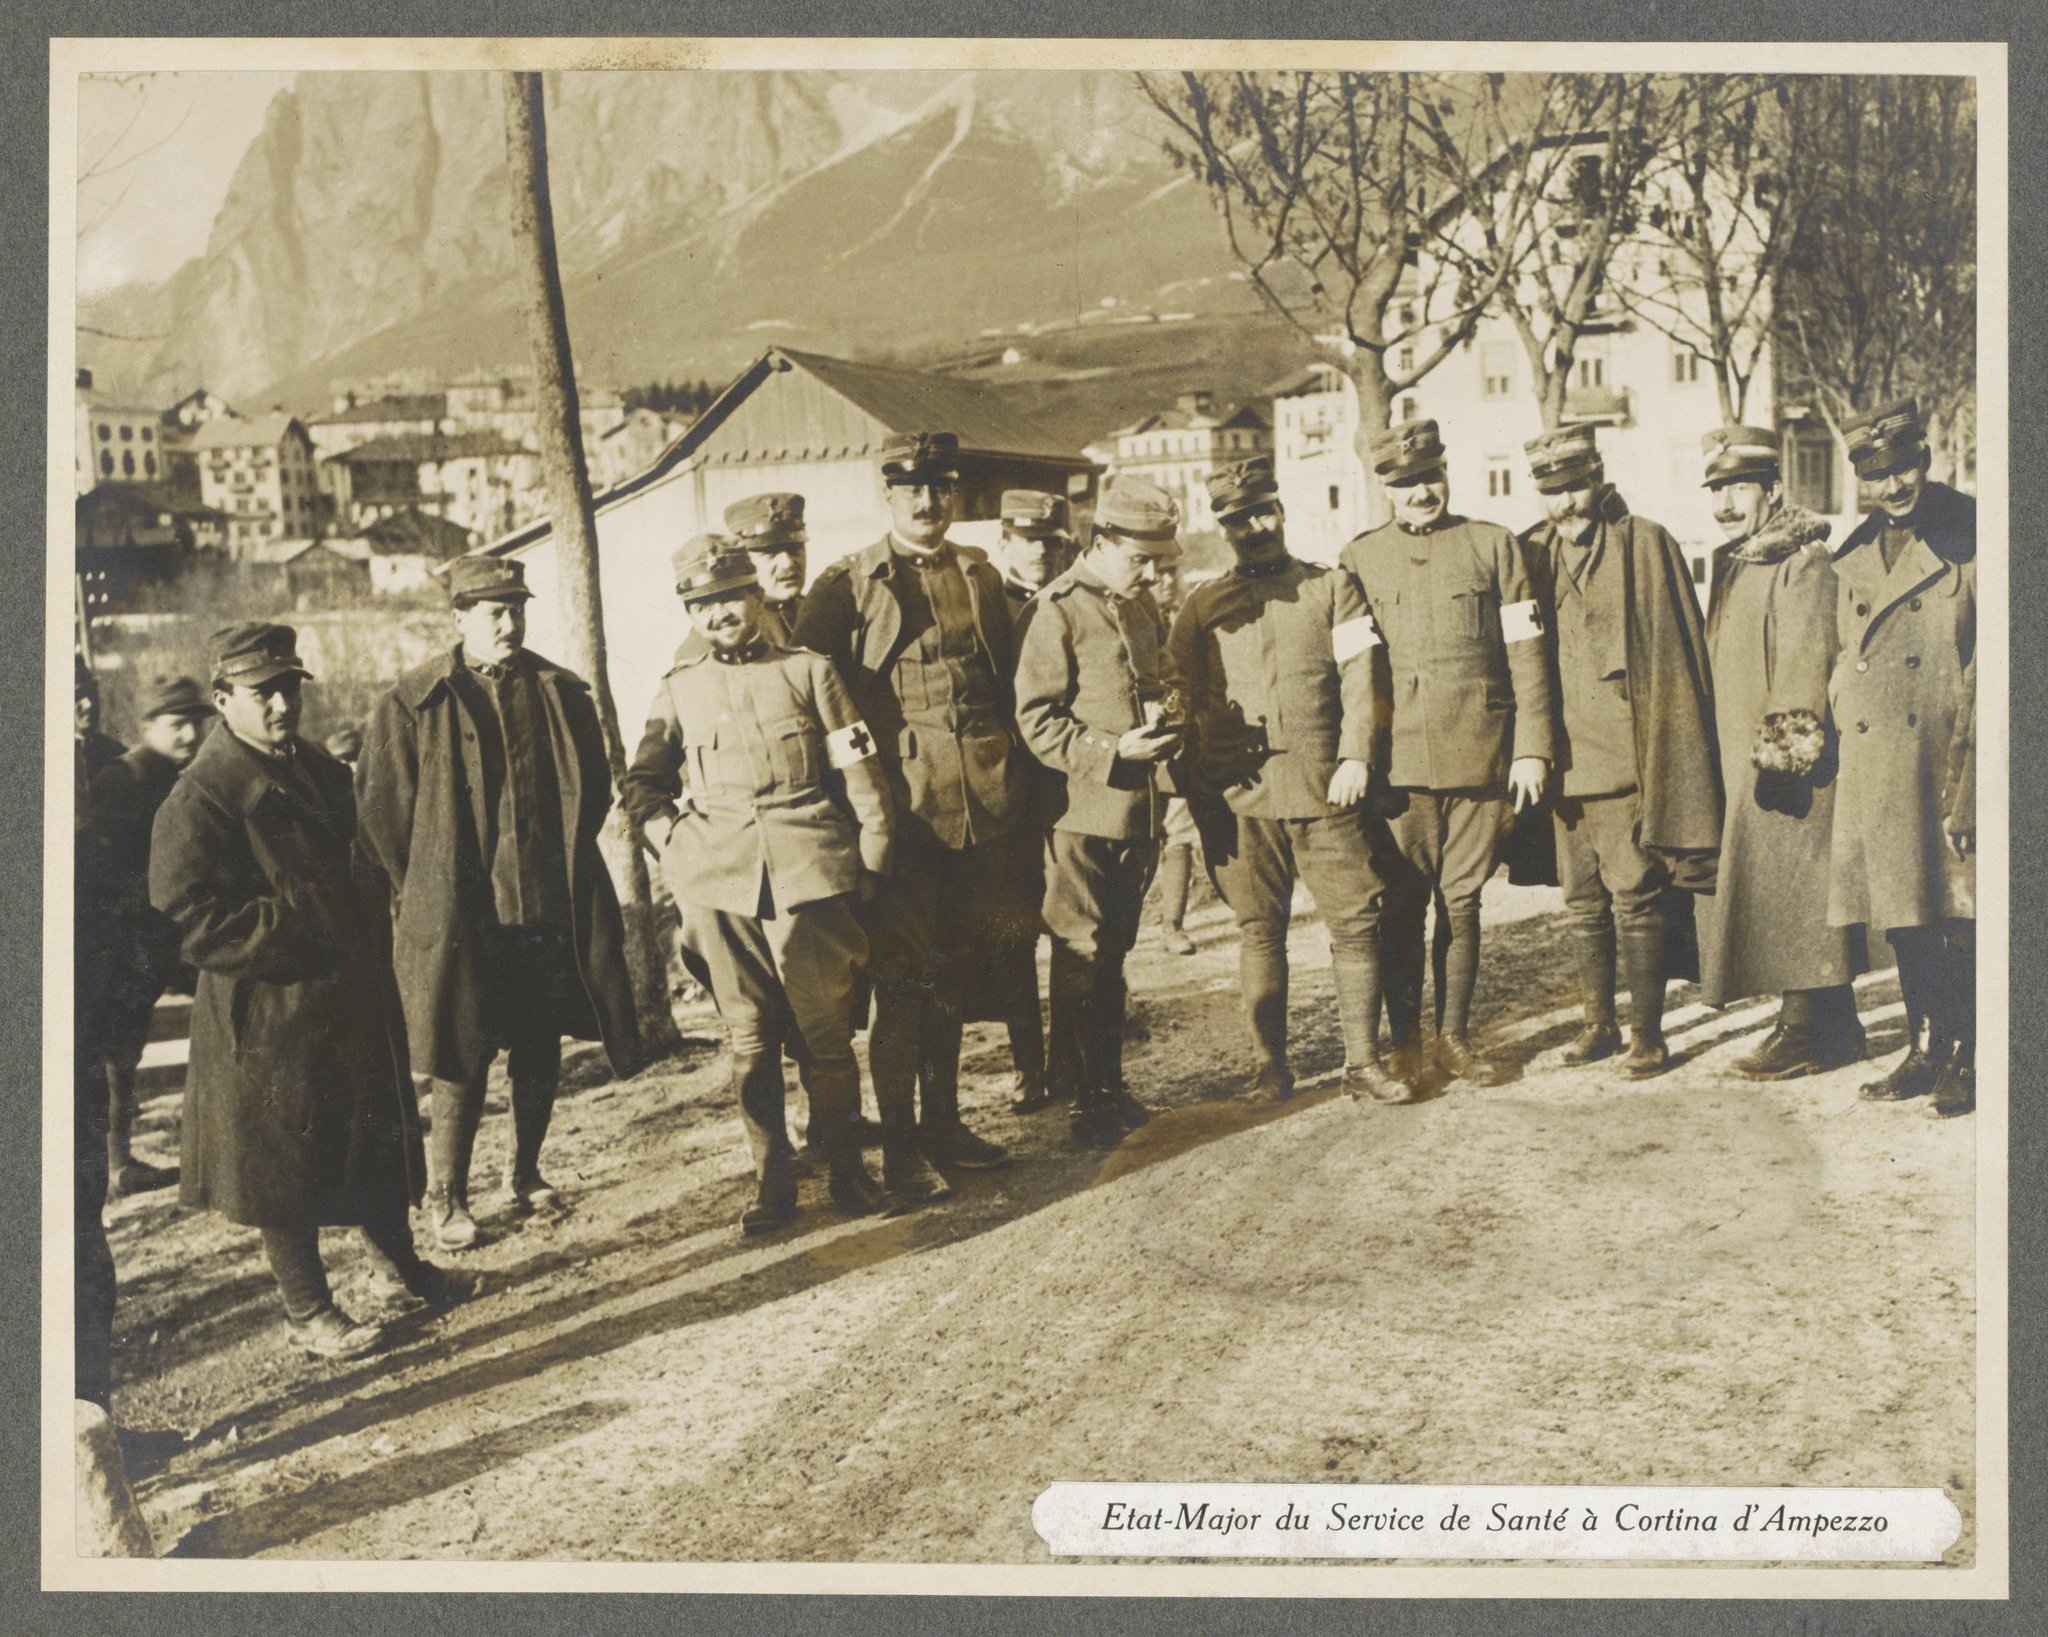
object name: photograph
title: Italiaanse militaire staf van de Medische dienst in Cortina d'Ampezzo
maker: henri de rothschild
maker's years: 1872-1947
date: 1916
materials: photographic support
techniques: gelatin silver print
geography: cortina d'ampezzo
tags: war (+ land forces)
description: Onderdeel van Fotoalbum Medische missie H. de Rothschild naar het Italiaanse front 1916.